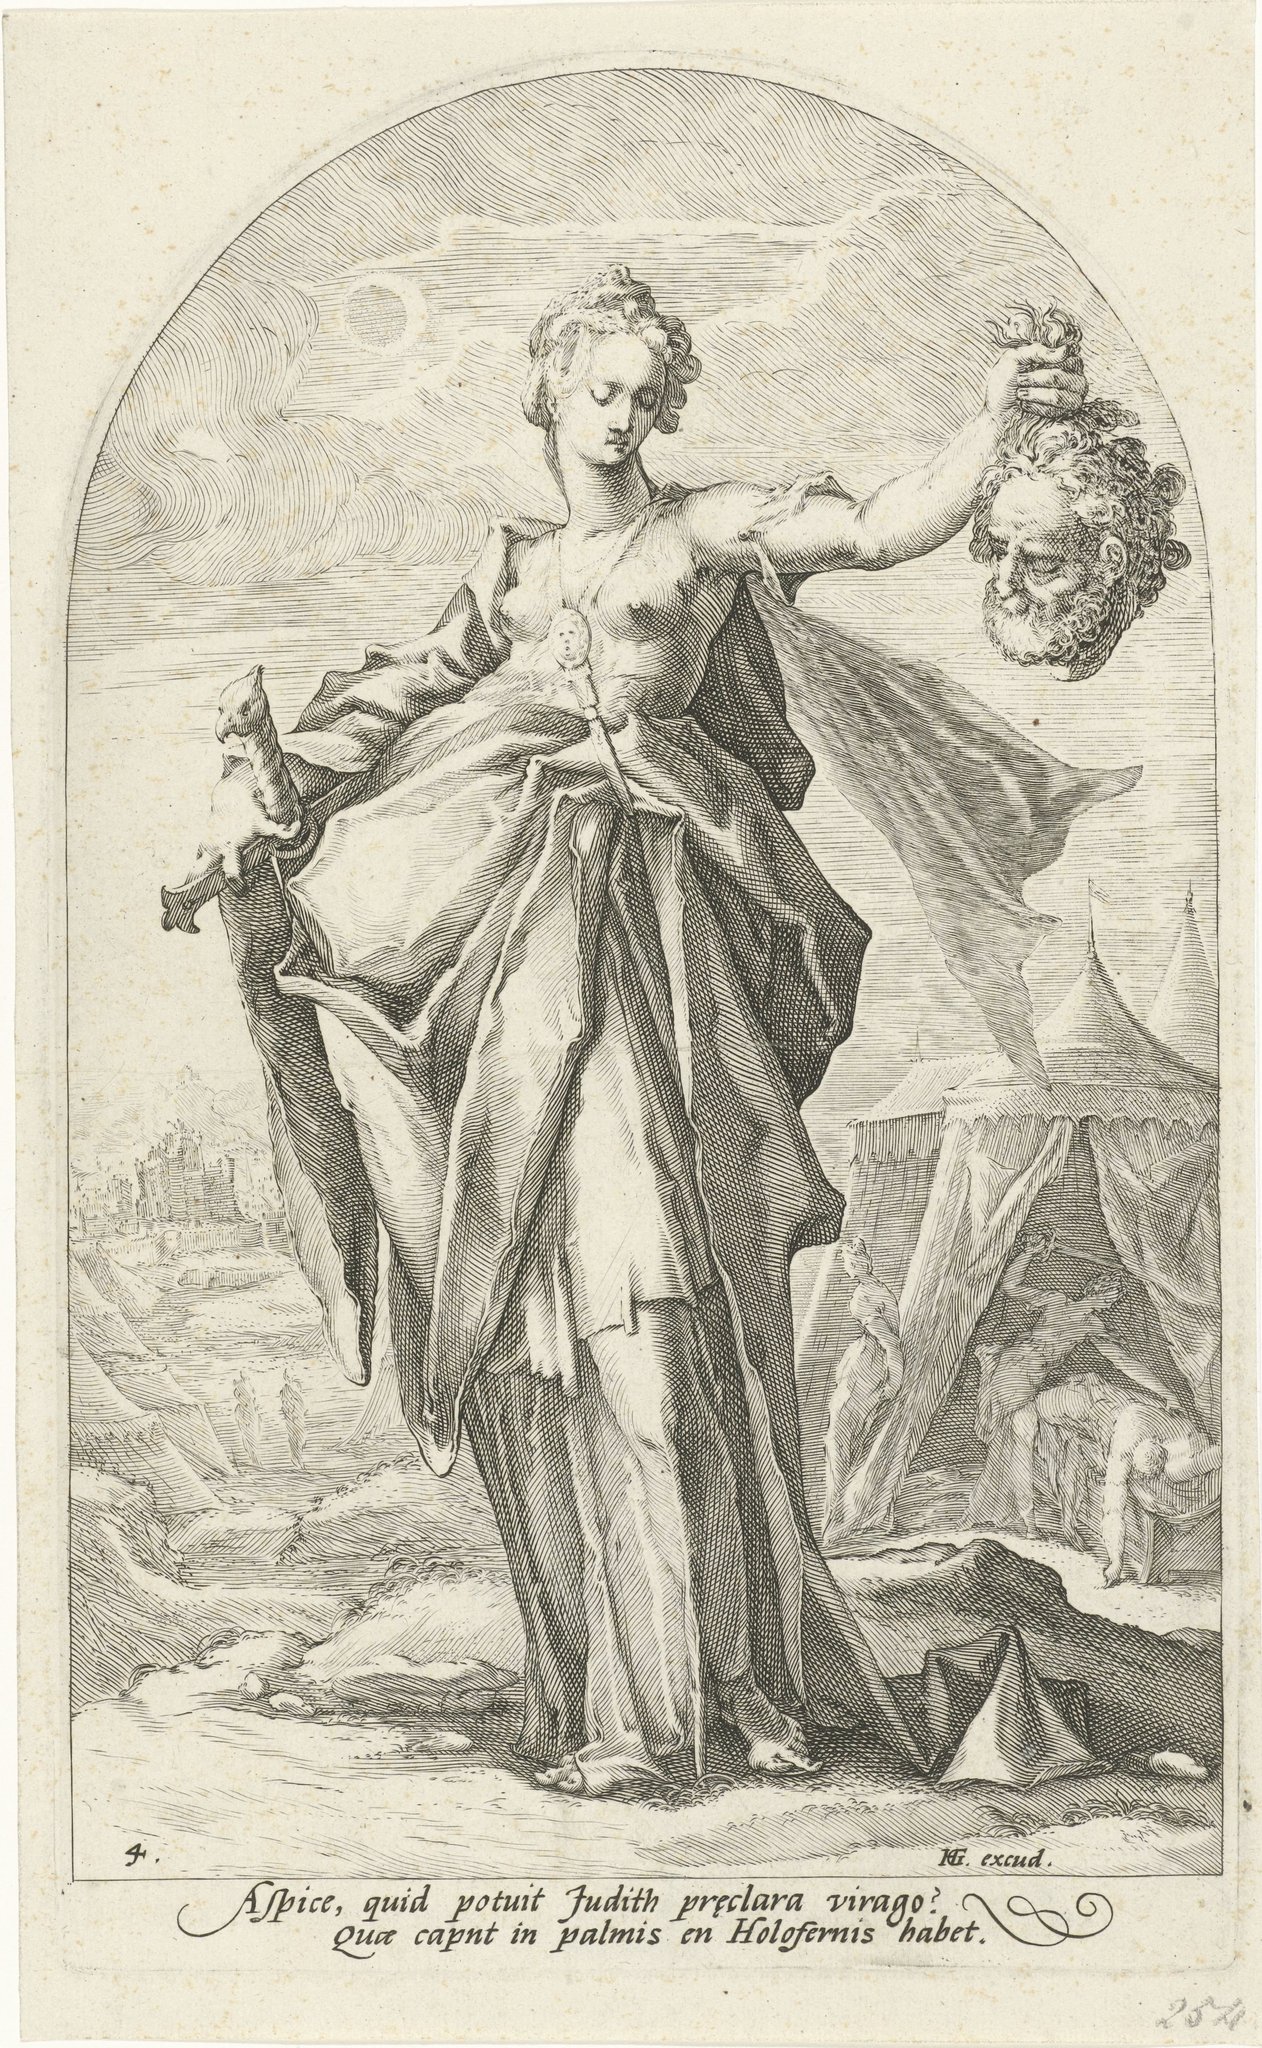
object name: print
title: Helden en heldinnen van het Oude Testament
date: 1585-1589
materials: paper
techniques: engraving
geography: haarlem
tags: judith with holofernes' head and the sword, holofernes beheaded by judith with his own sword; the maidservant may be keeping watch, female persons from the old testament (with name) (not in biblical context)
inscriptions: collector's mark: Lugt 2228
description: Judit met het hoofd van Holofernes in de ene, het zwaard in de andere hand. Op de achtergrond de scène waarin zij de legeraanvoerder in zijn tent het hoofd afhakt, terwijl haar dienstmaagd op wacht staat.